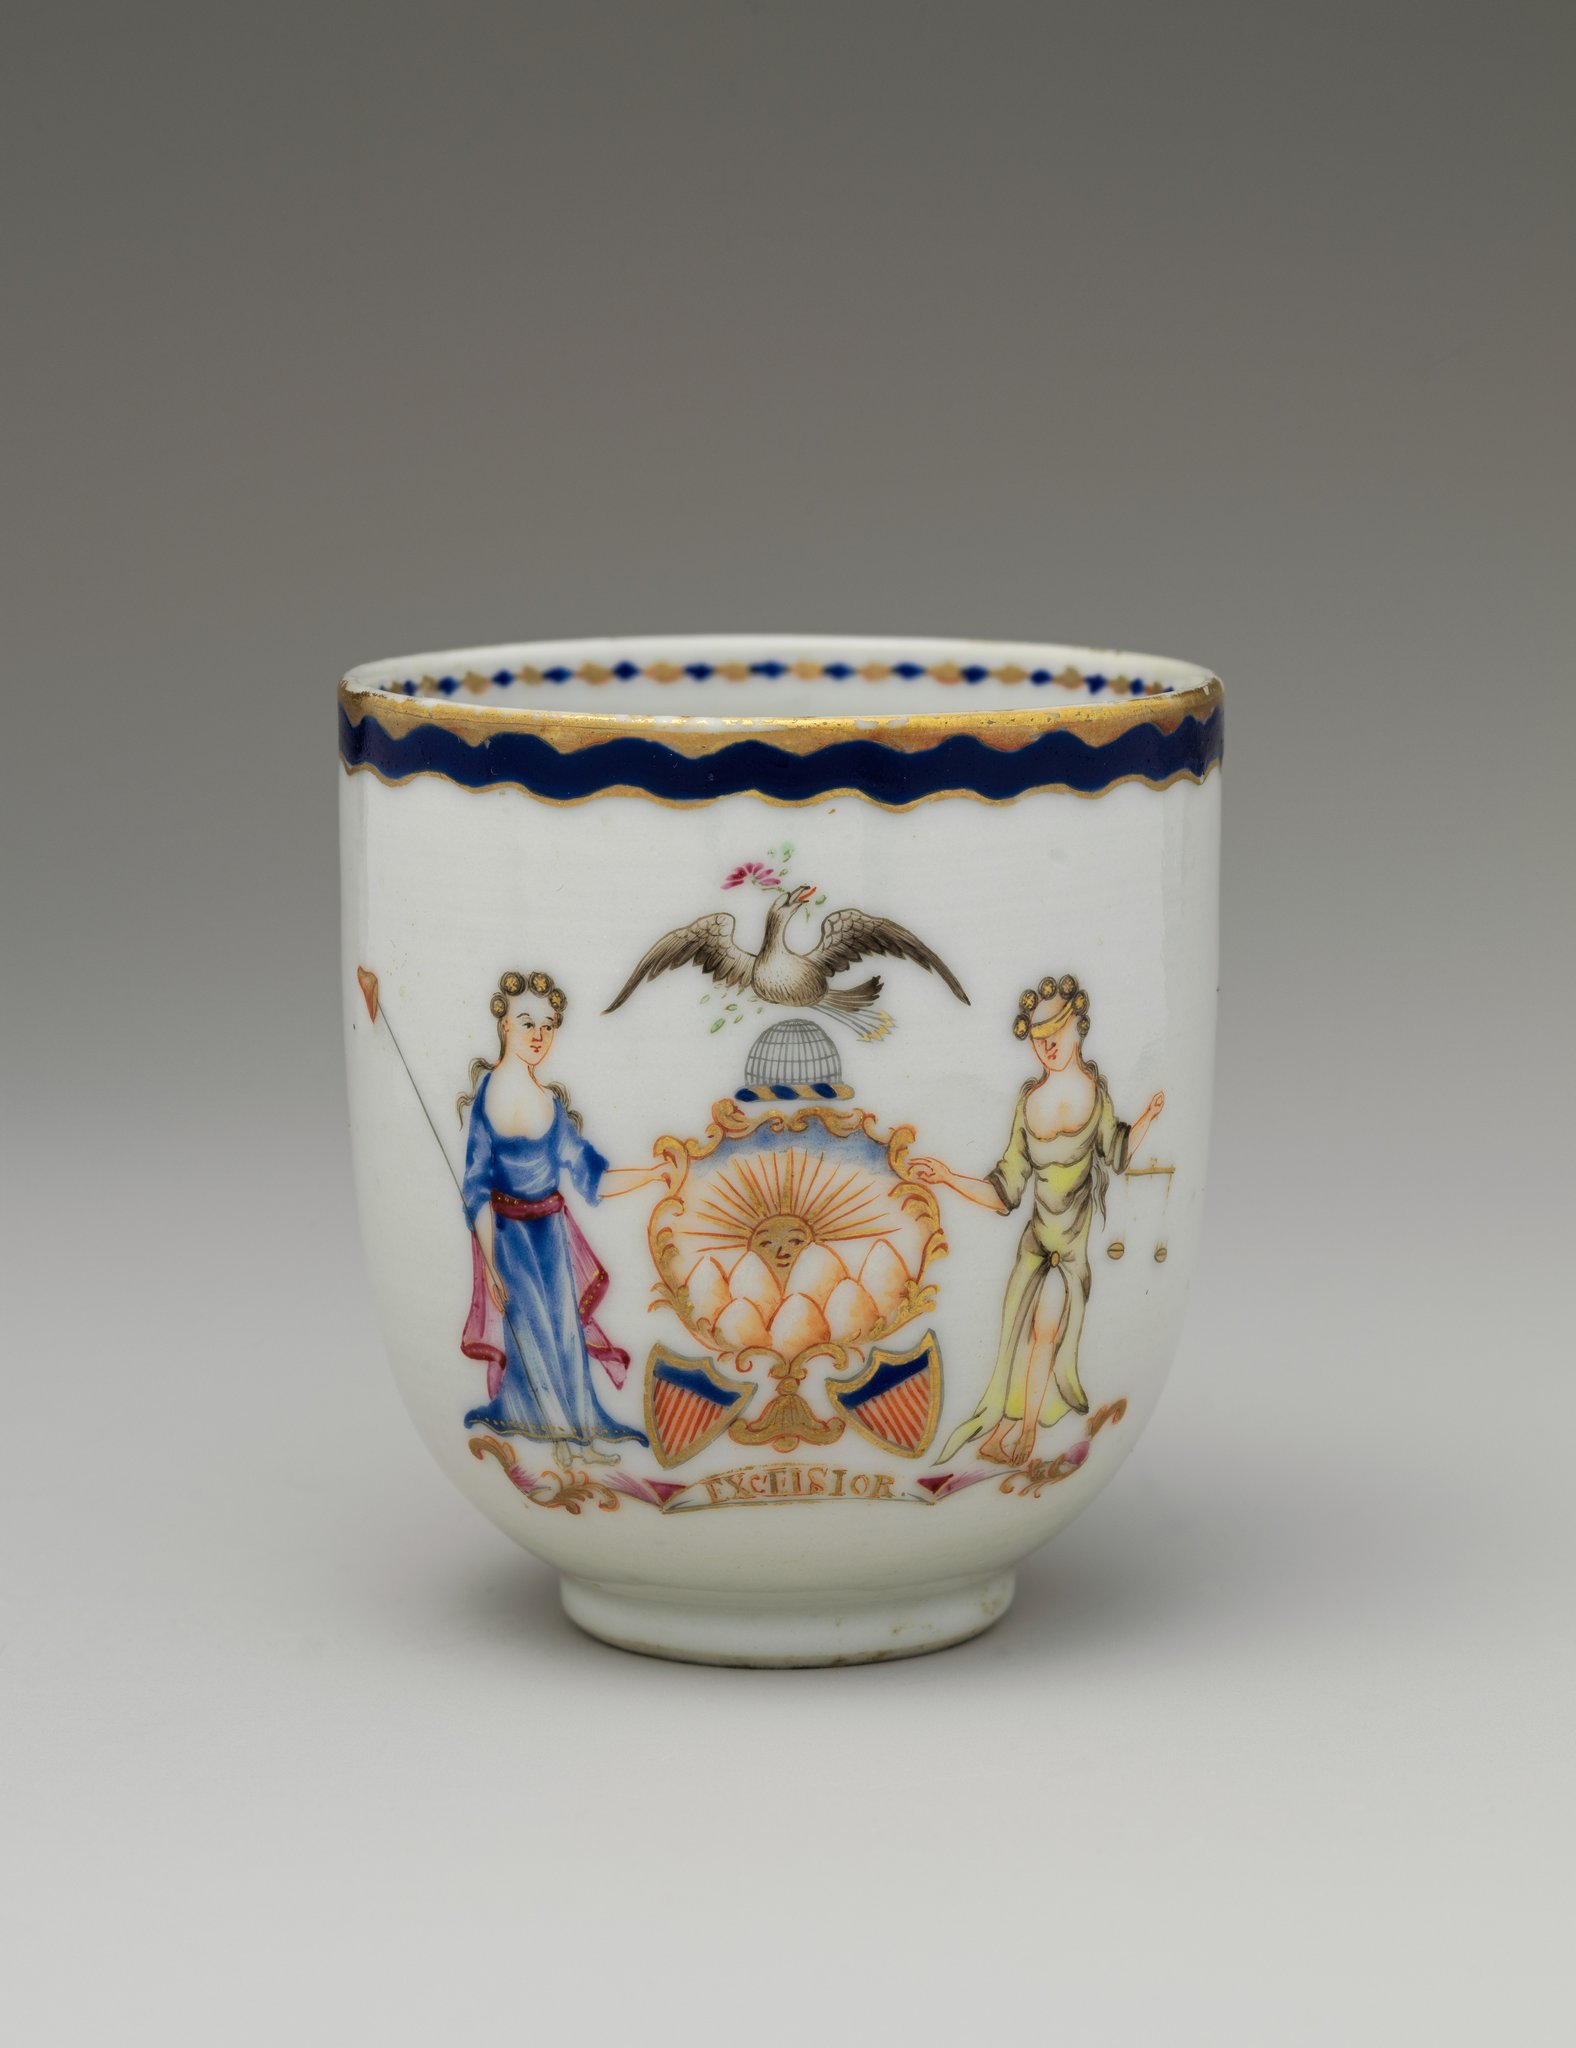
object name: cup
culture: chinese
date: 1785-1805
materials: porcelain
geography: china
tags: coat of arms